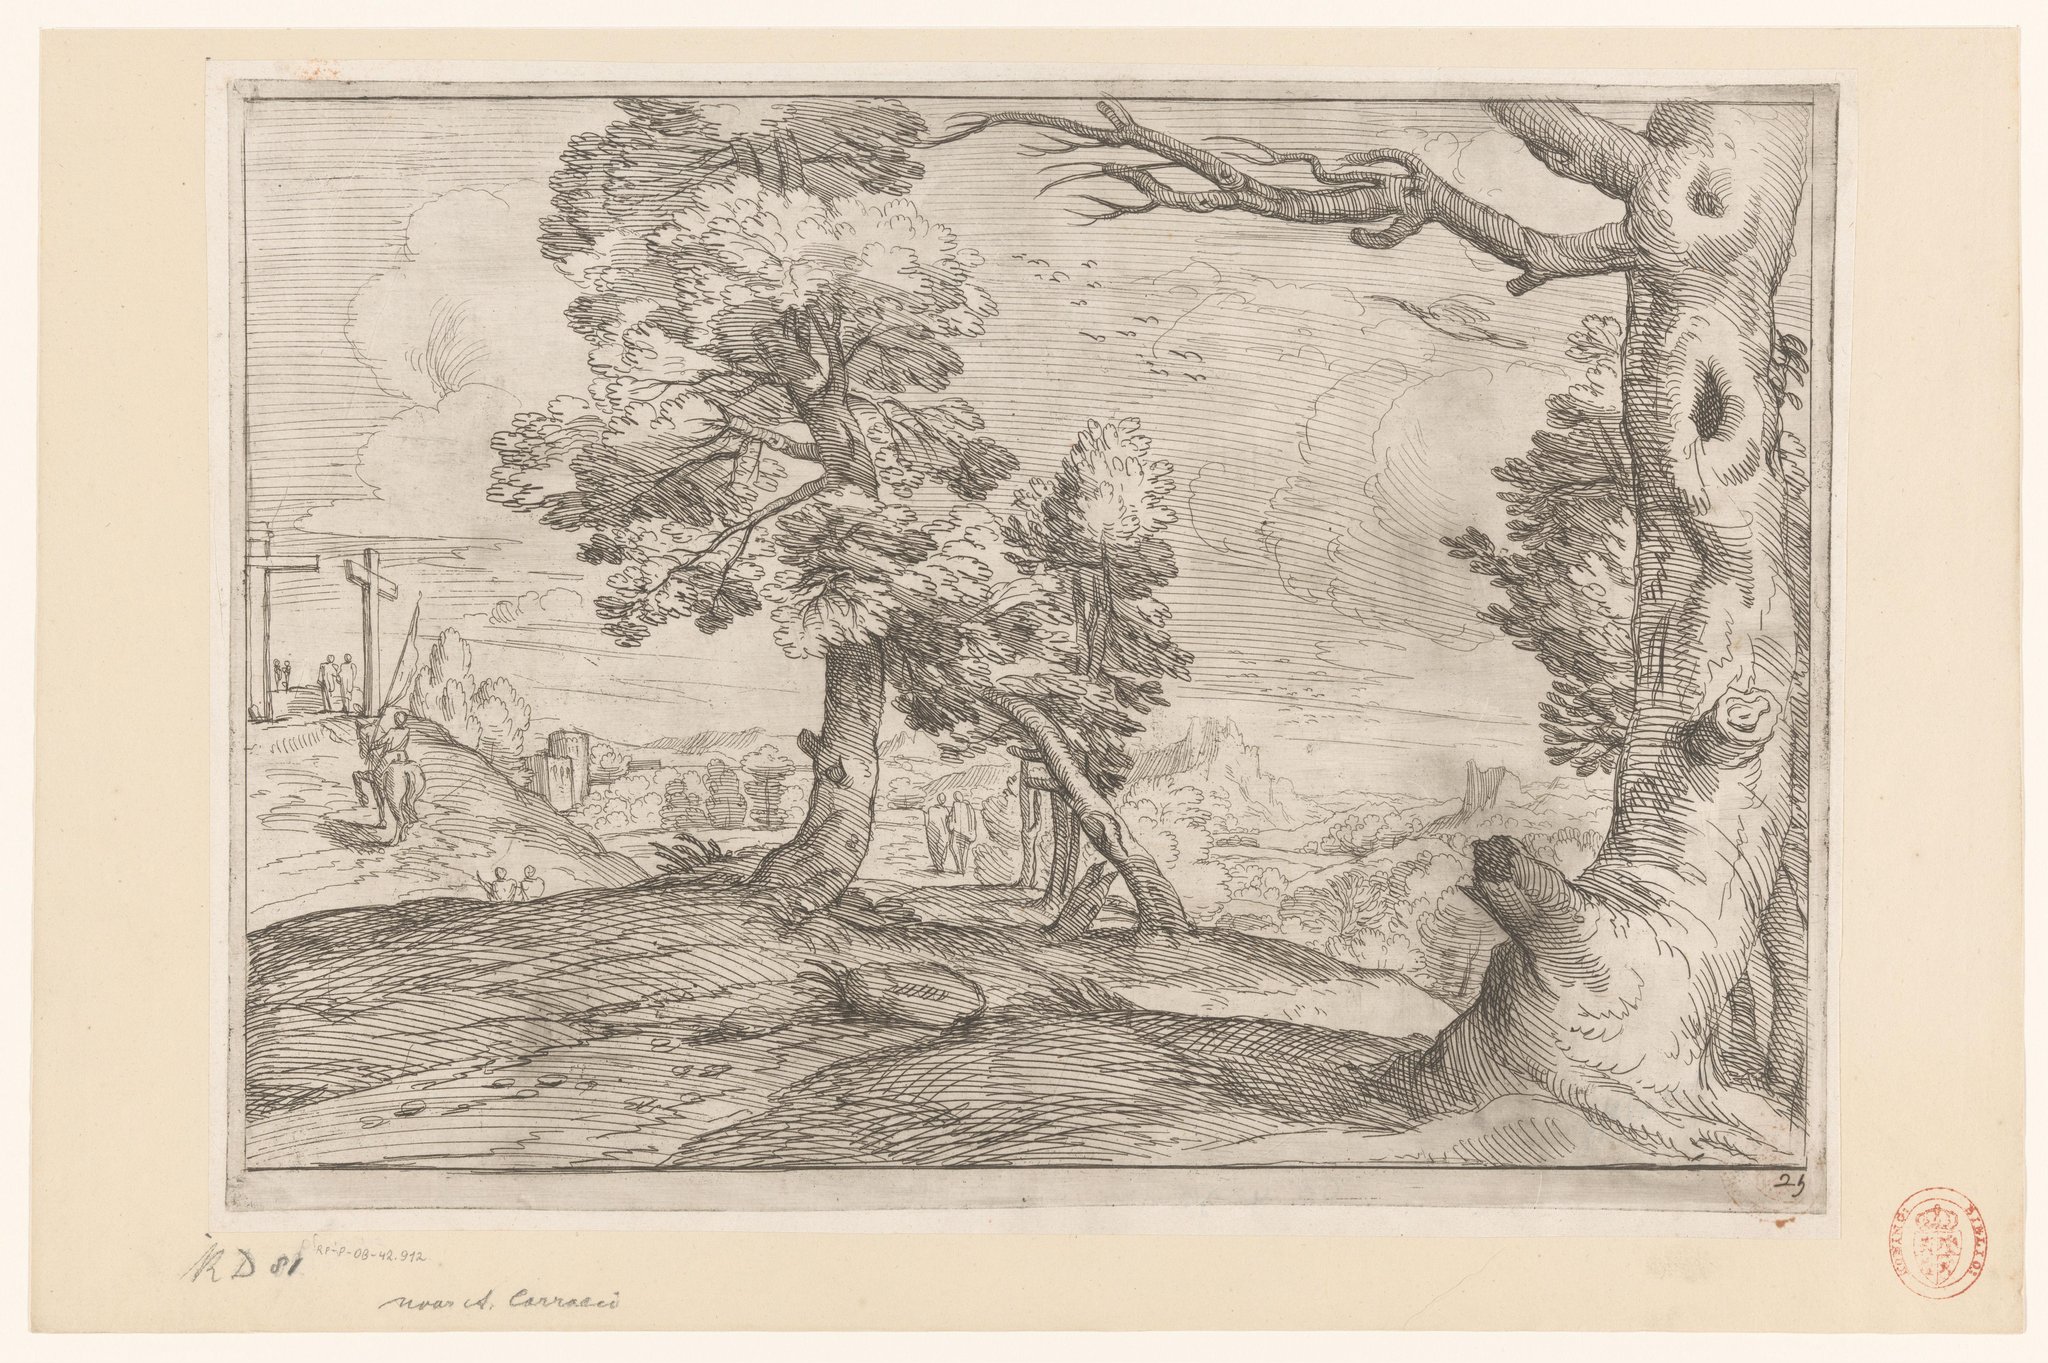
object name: print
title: Landschap met de Kruisberg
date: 1659-1695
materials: paper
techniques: engraving, etching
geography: france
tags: landscapes, the cross(es) in the middle distance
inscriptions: collector's mark: Lugt 240